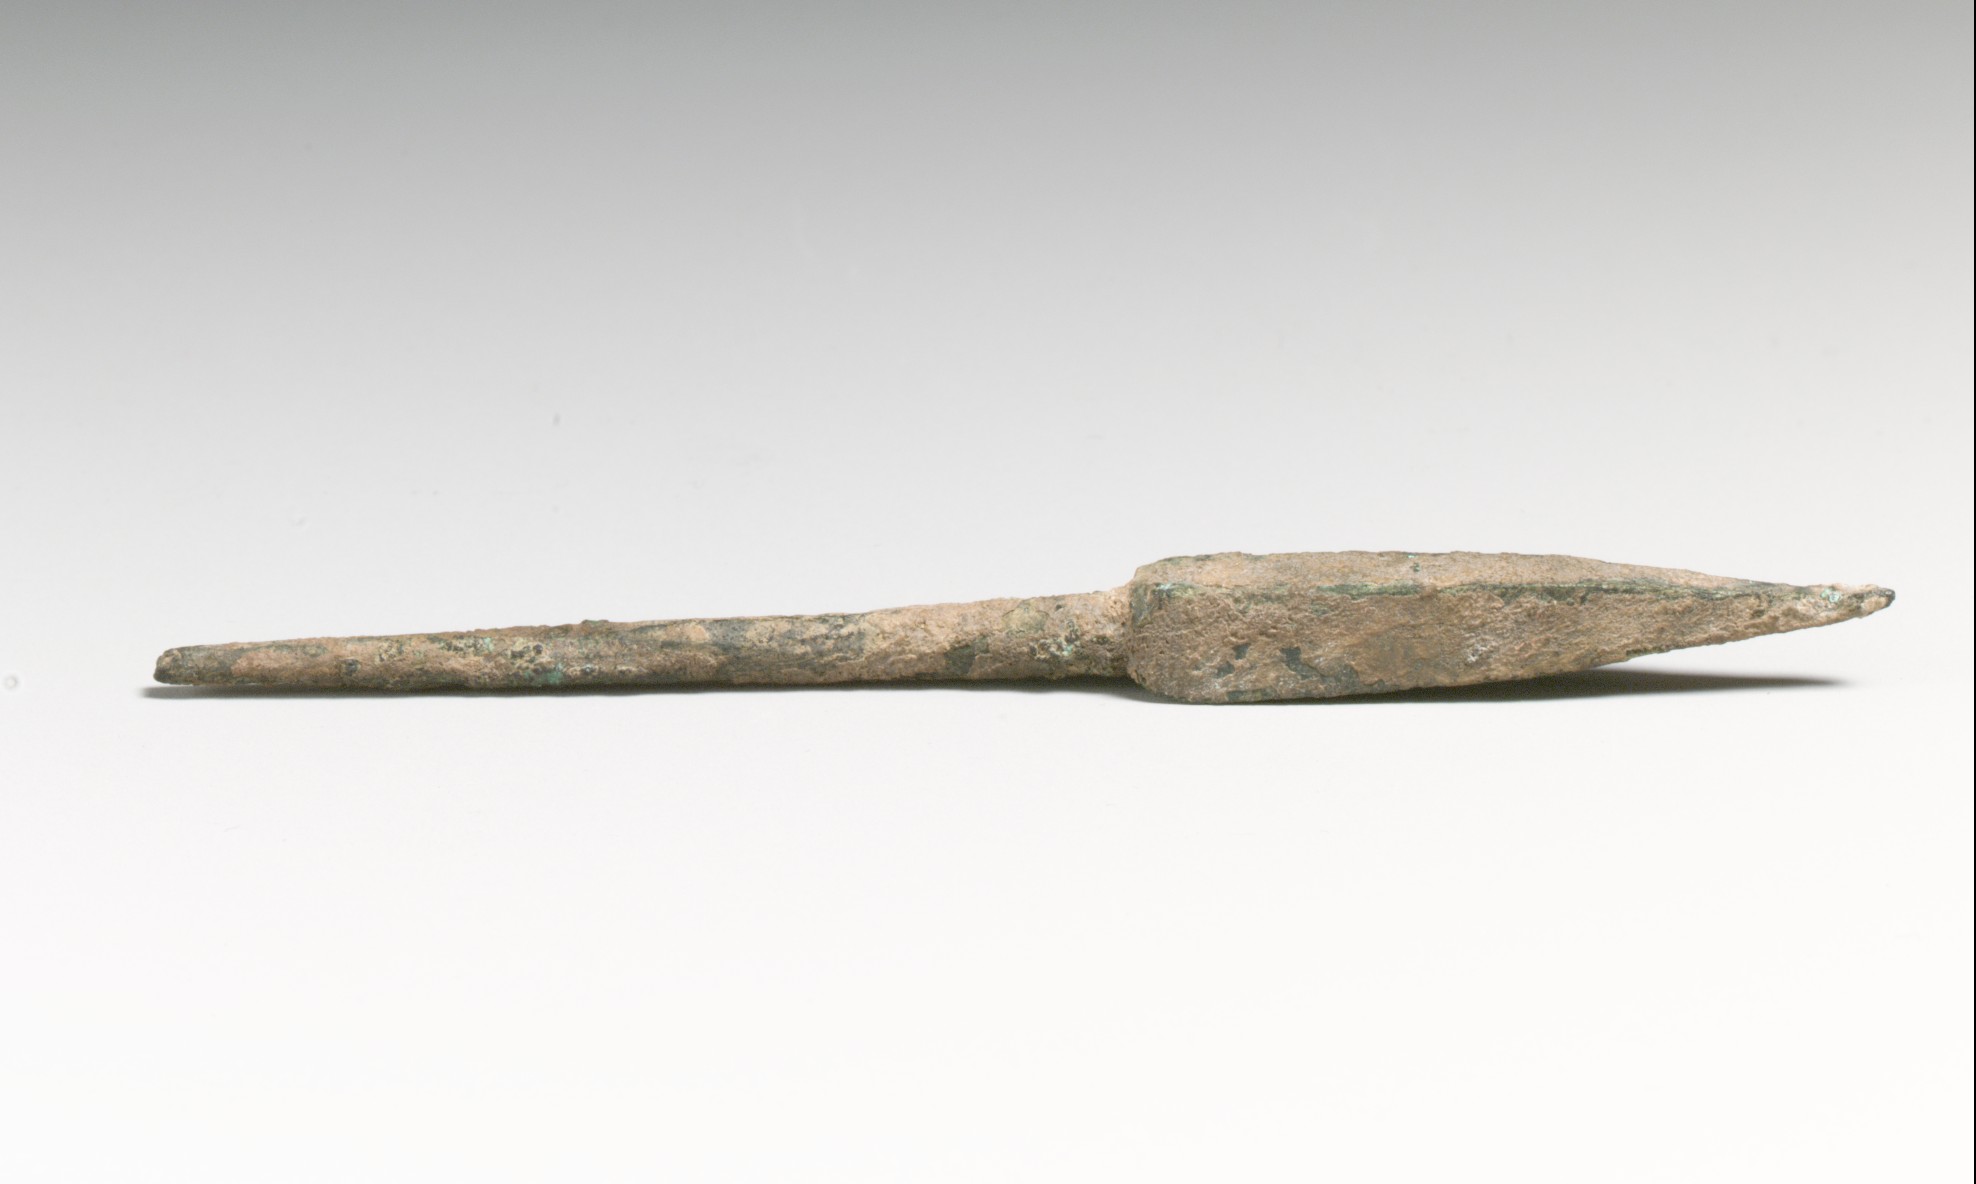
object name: arrowhead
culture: greek, cypriot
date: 480-330 BCE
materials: bronze